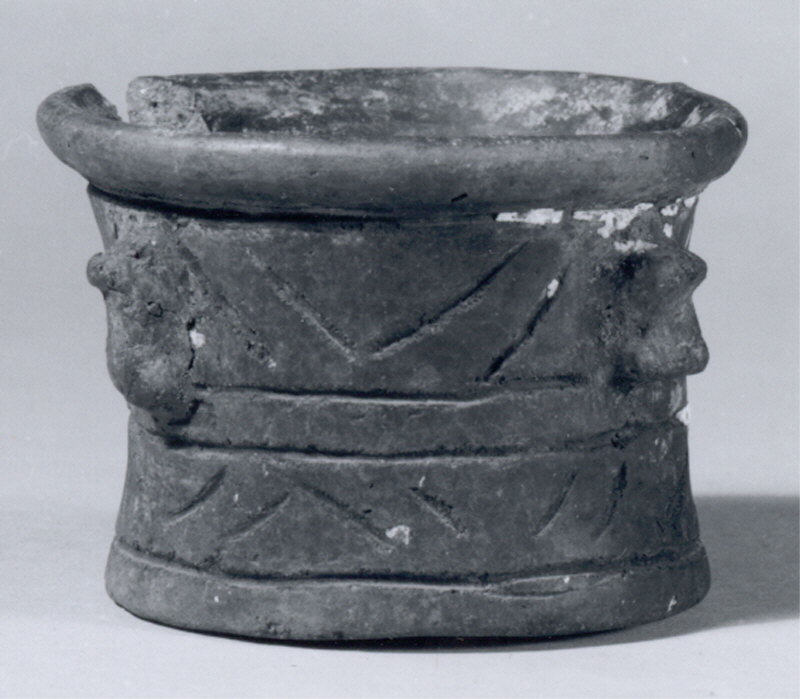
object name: cup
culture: iranian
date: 1000 BCE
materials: ceramic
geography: northwestern iran